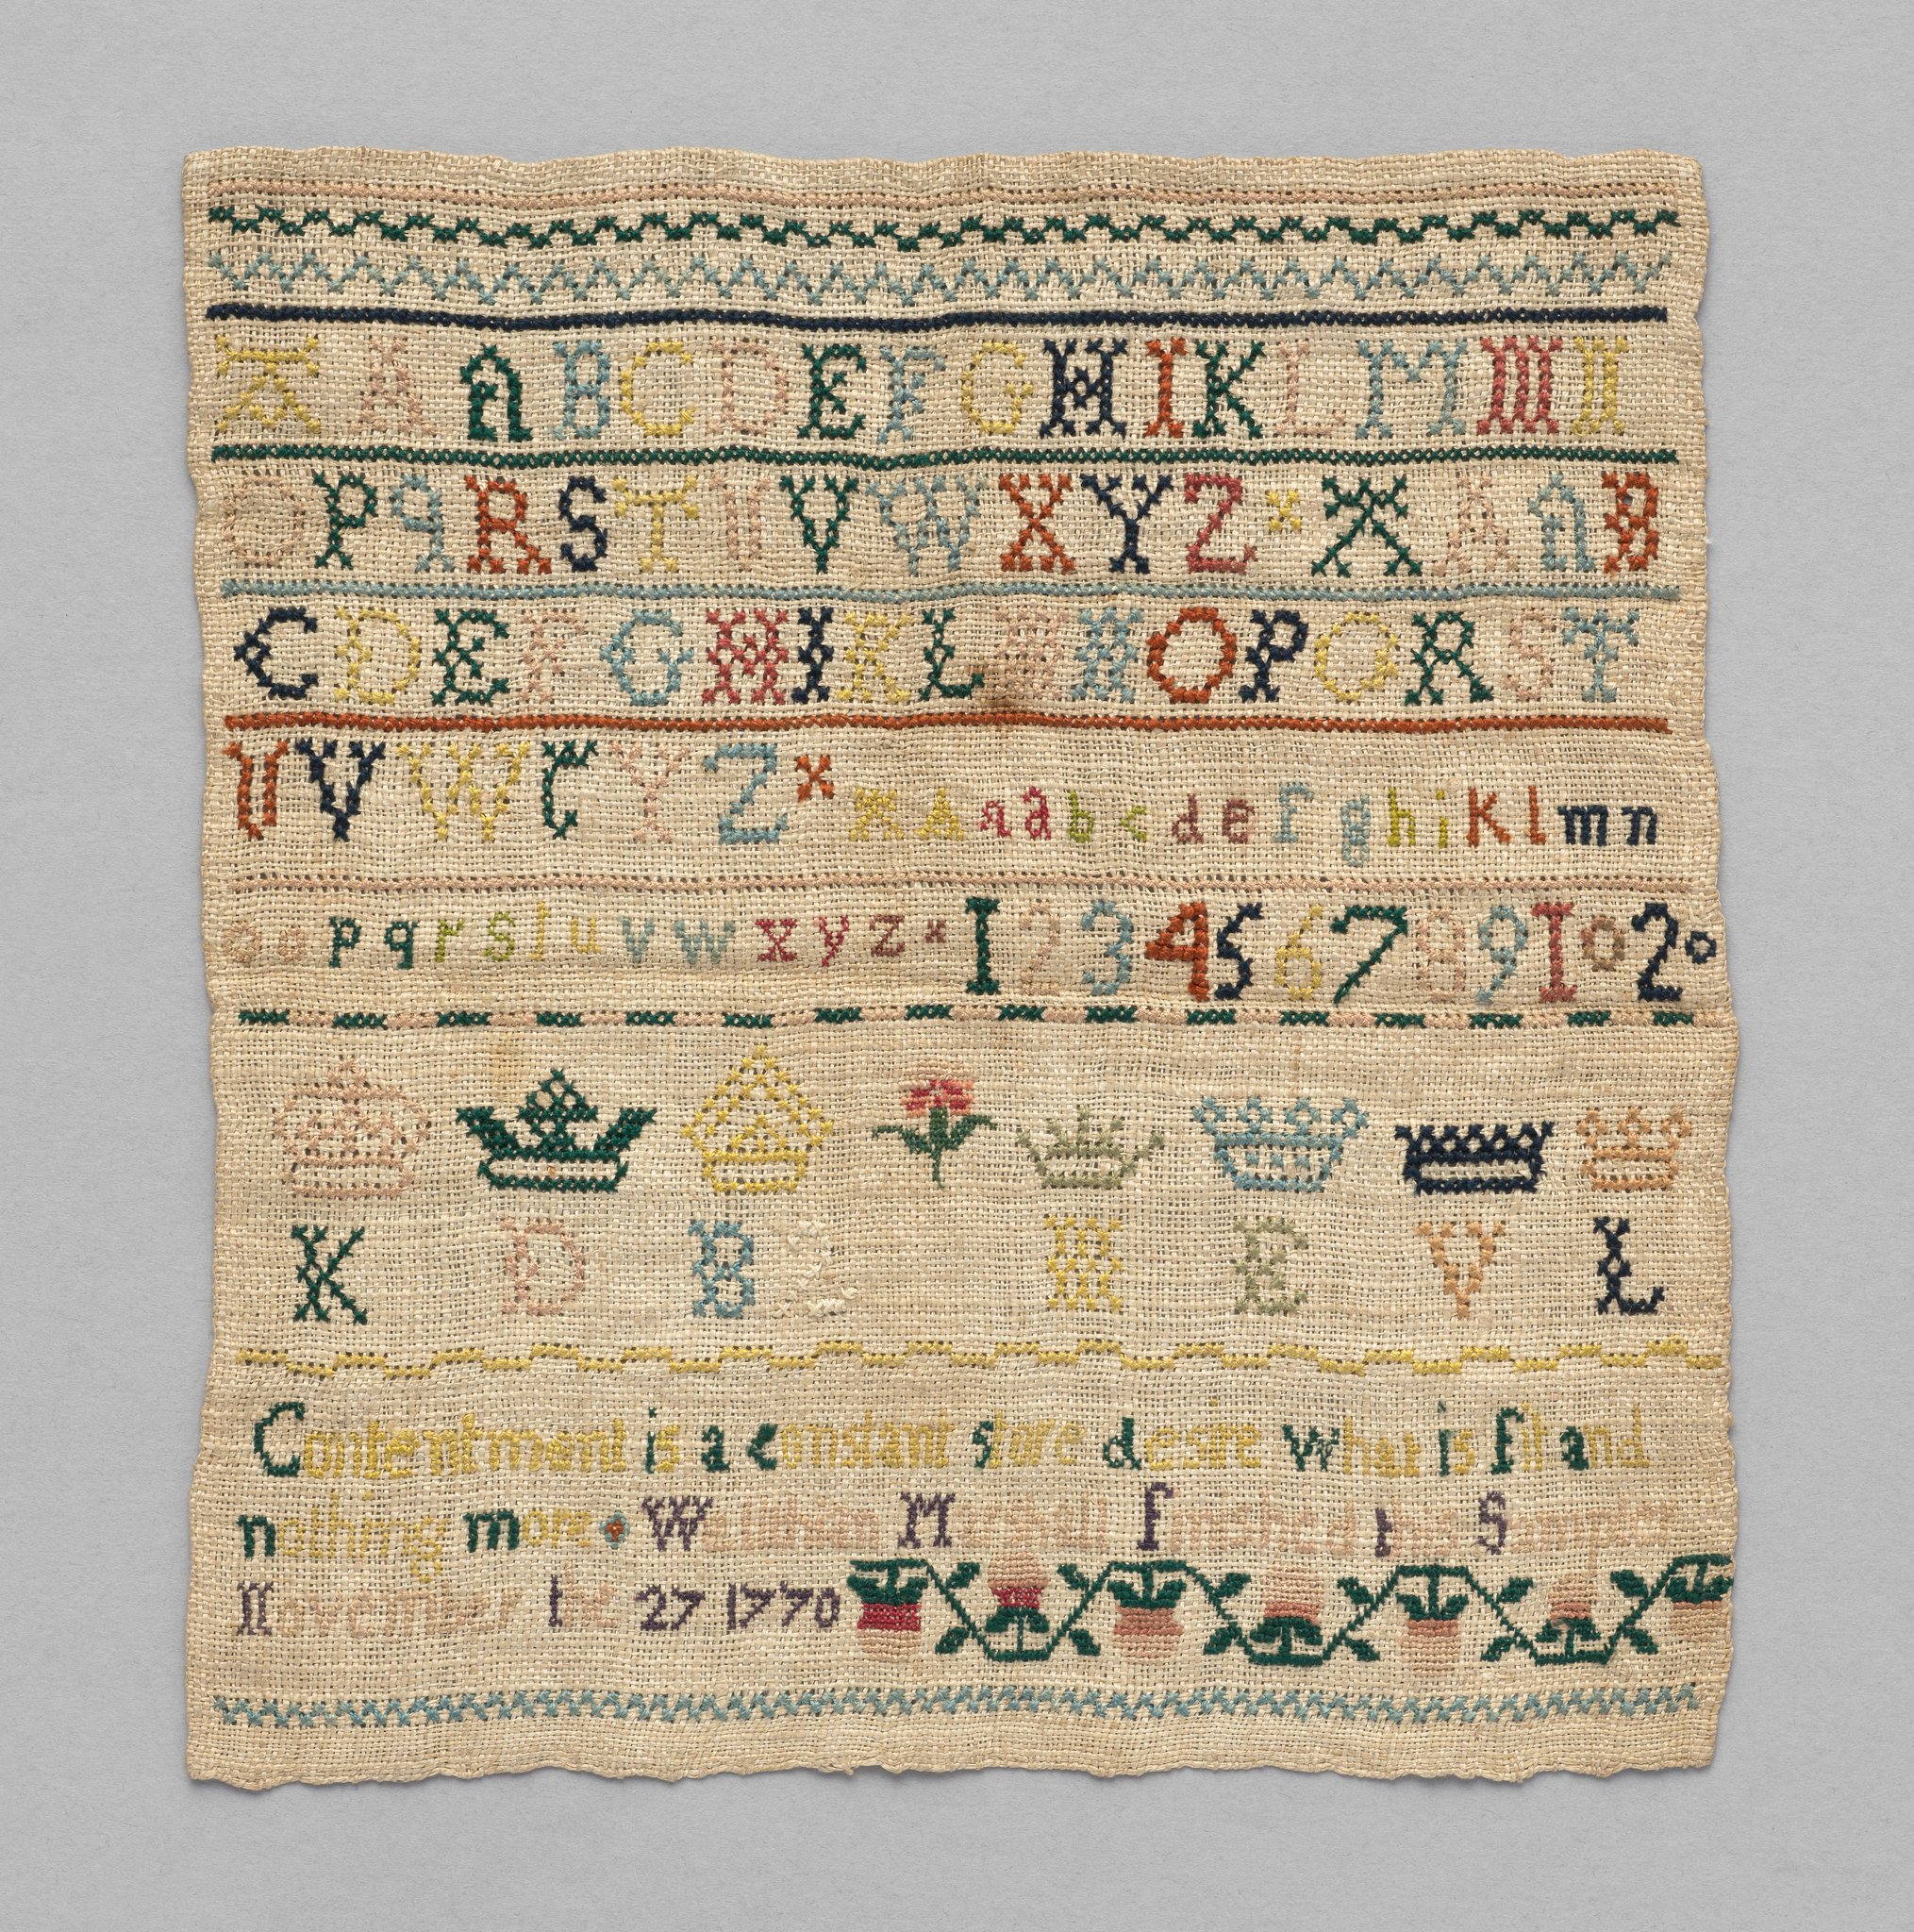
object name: sampler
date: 1770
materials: linen, silk